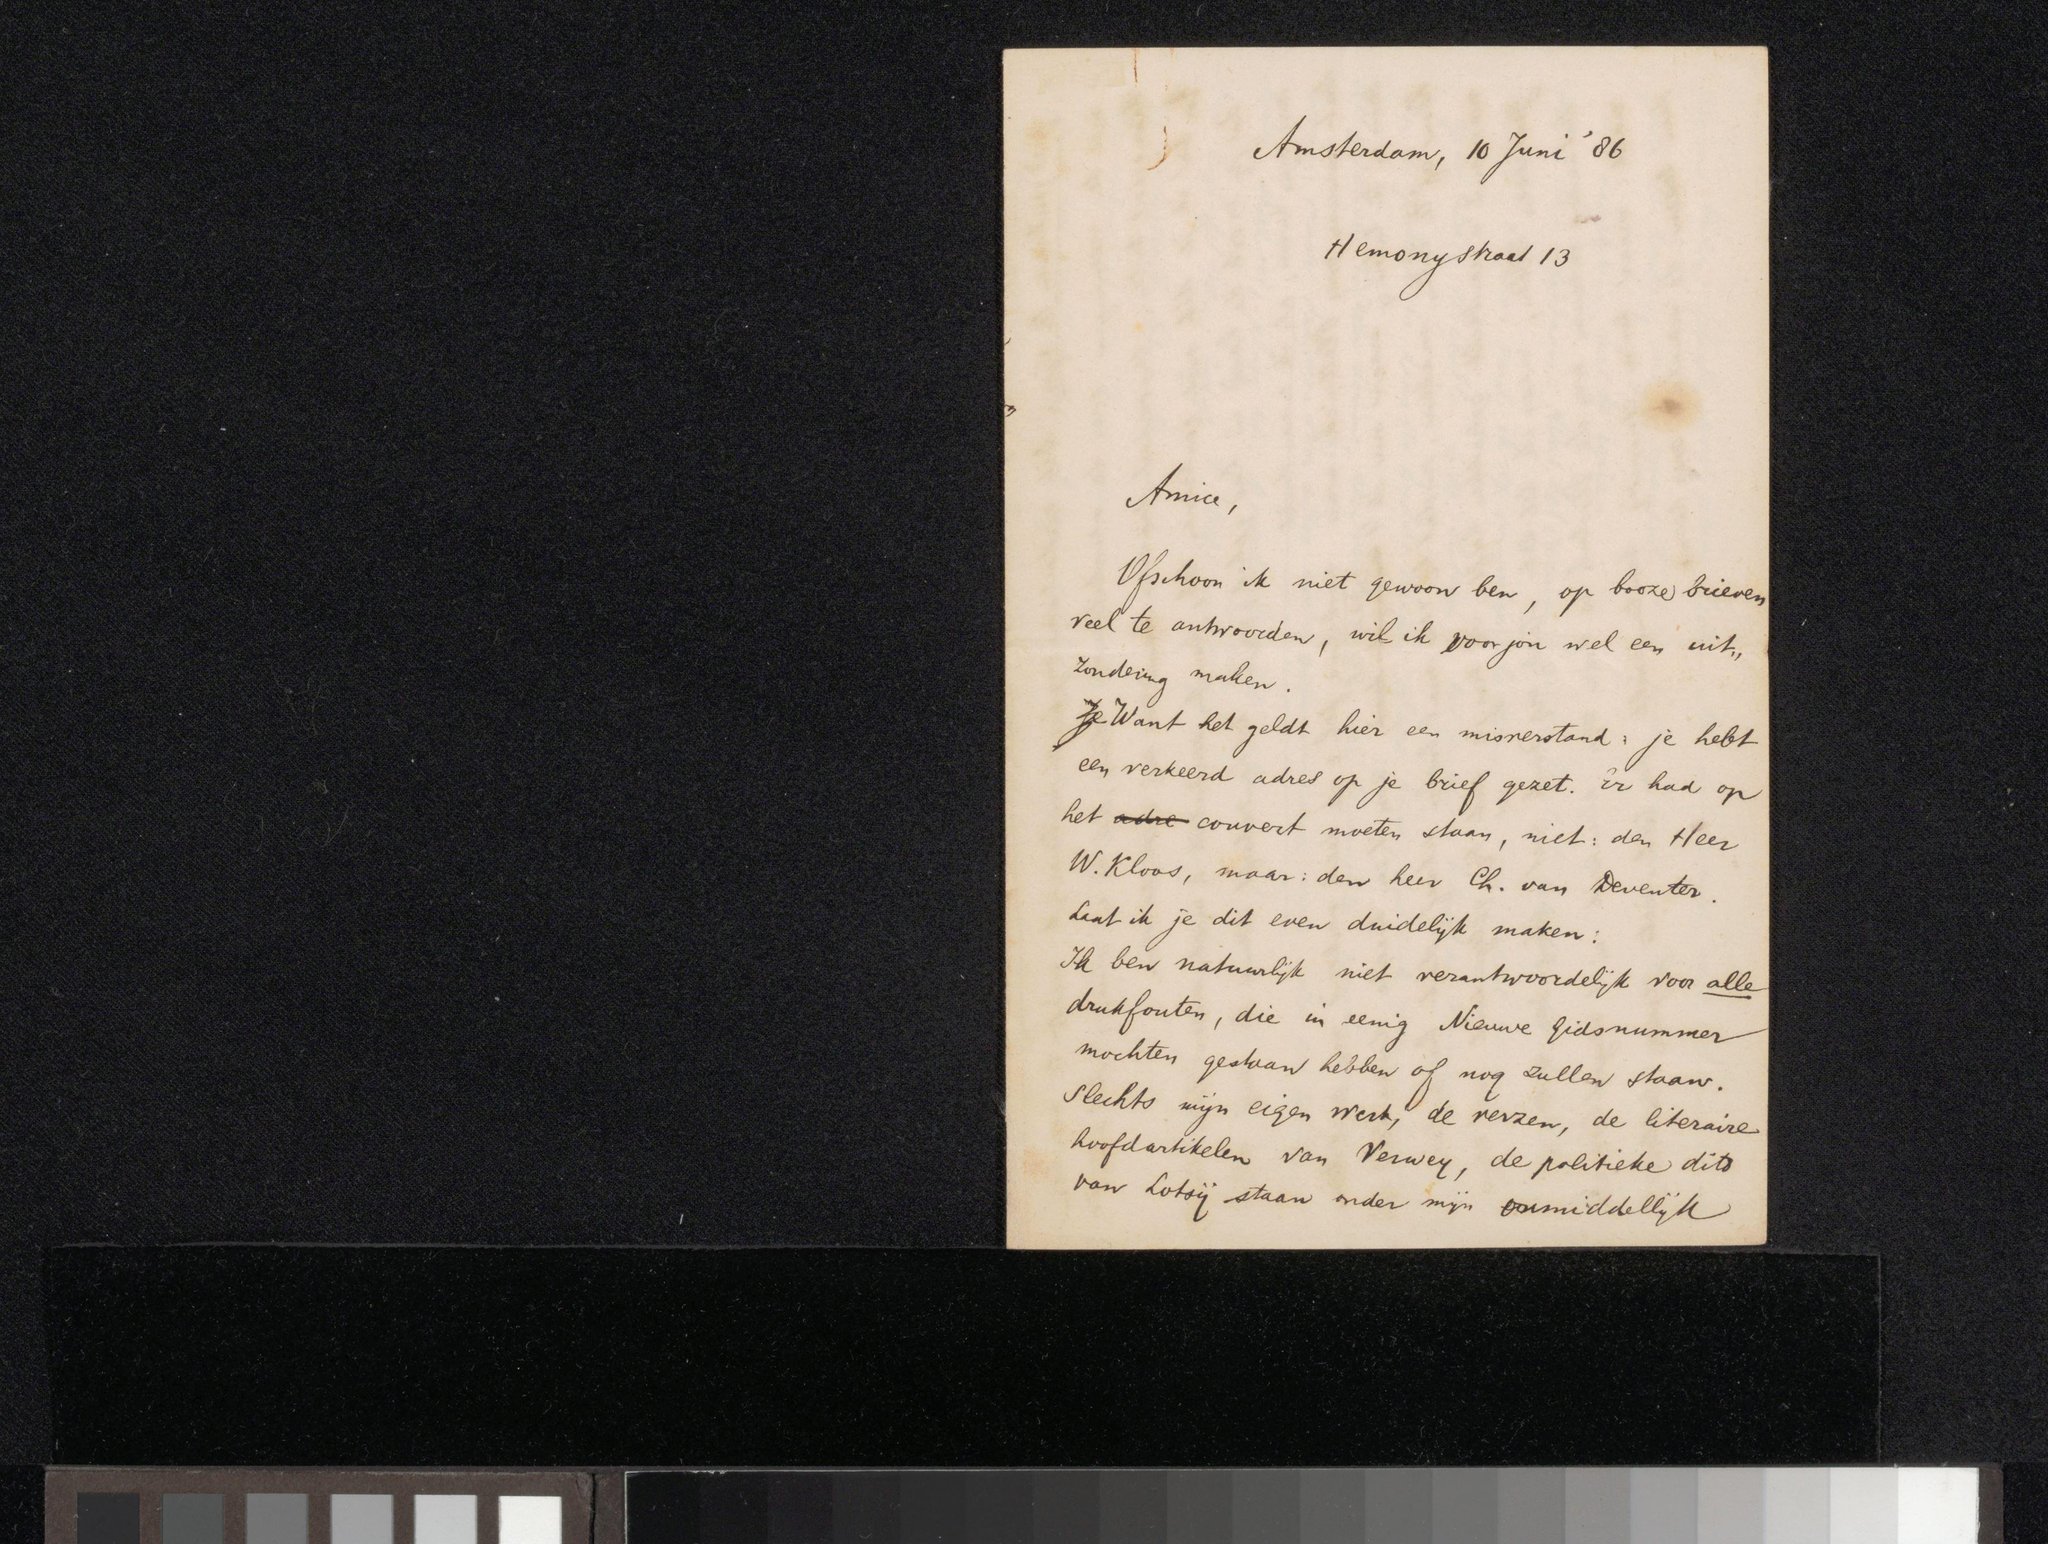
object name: postcard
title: Briefkaart aan Jan Veth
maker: willem kloos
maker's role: dichter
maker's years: 1859-1938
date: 1886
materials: cardboard, ink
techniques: pen, writing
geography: amsterdam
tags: painter, draughtsman, designer, jan veth, albert verwey, dordrecht, conrad th. van deventer, passions, emotions, affections, the graphic arts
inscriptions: collector's mark: ‘RPK’